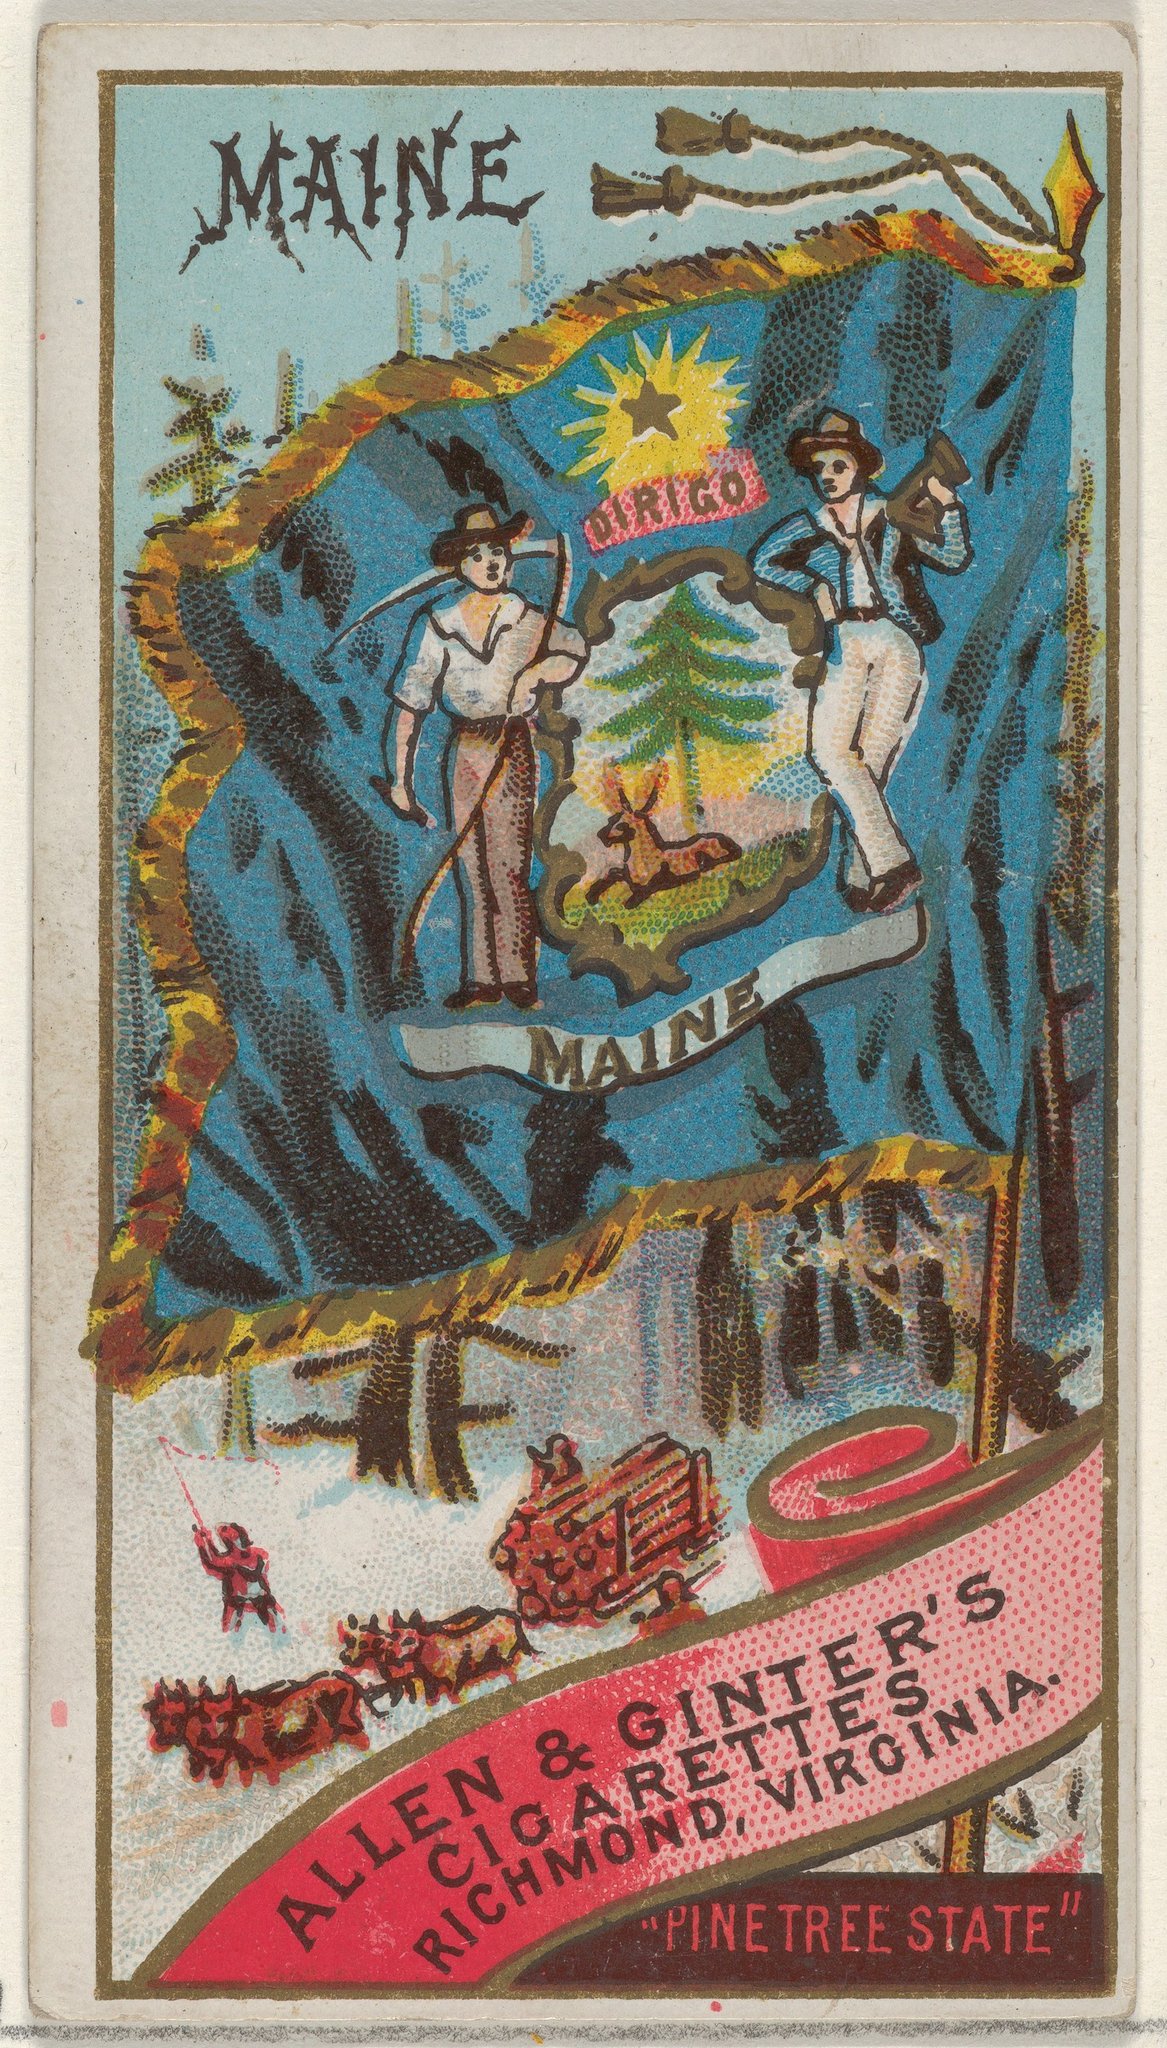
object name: print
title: Maine, from Flags of the States and Territories (N11) for Allen & Ginter Cigarettes Brands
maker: allen & ginter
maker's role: publisher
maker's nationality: american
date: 1888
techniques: color lithograph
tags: flags